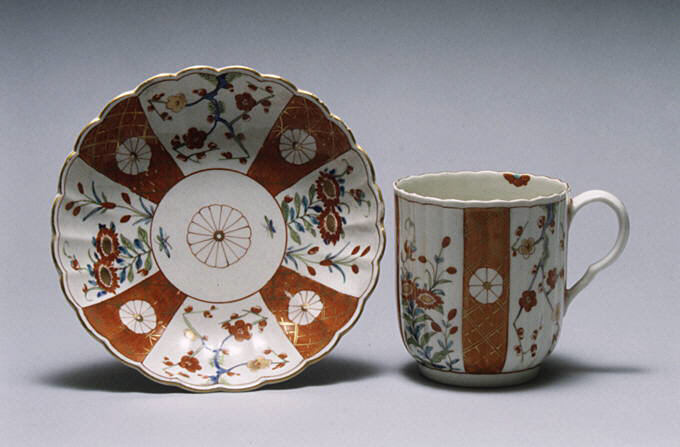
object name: cup and saucer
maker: worcester factory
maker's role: factory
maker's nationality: british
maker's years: 1751-2008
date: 1770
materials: soft paste porcelain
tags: flowers